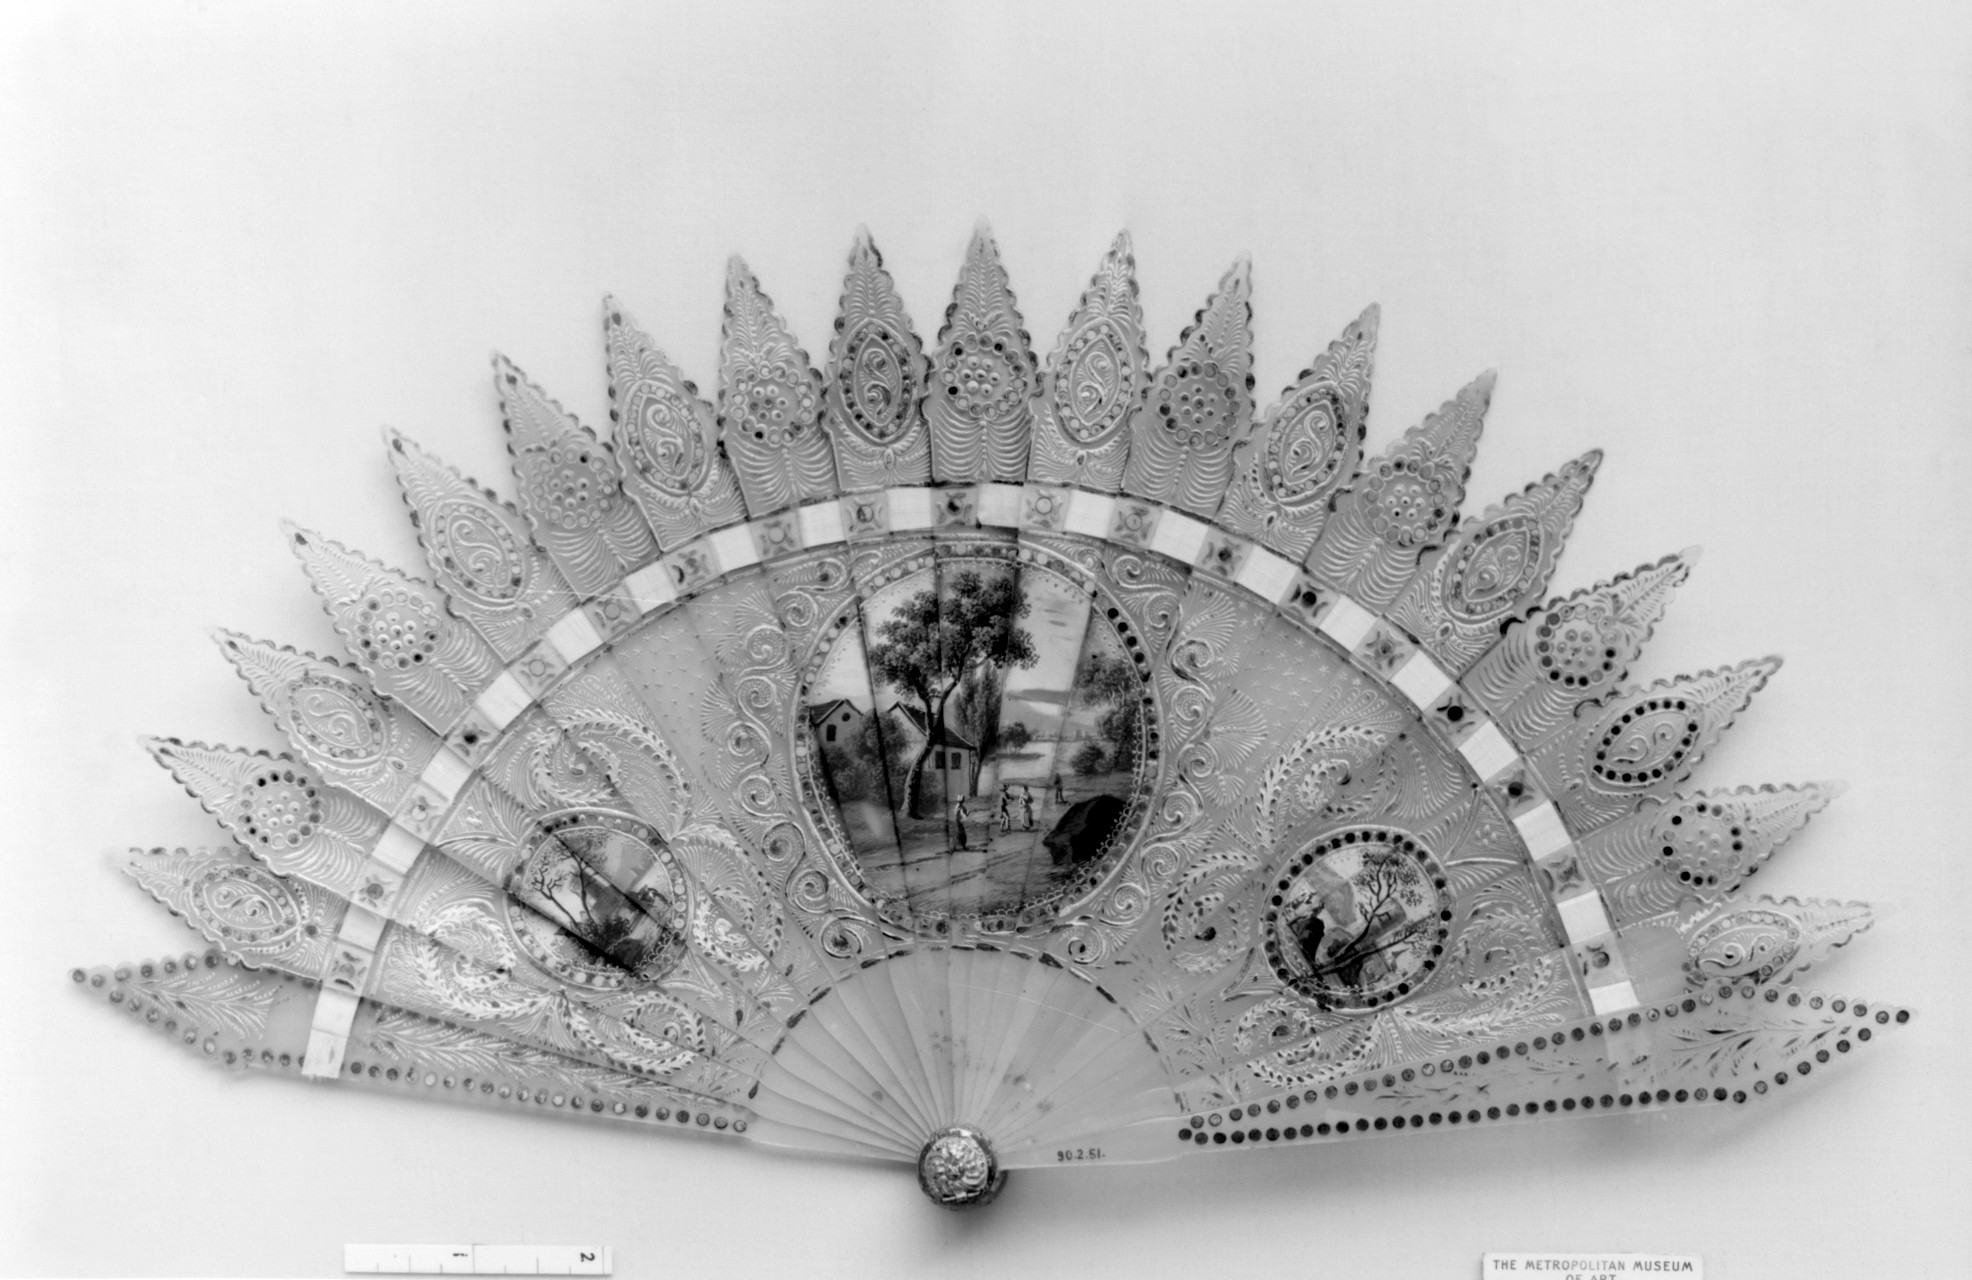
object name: fan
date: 1815-1840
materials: horn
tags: houses